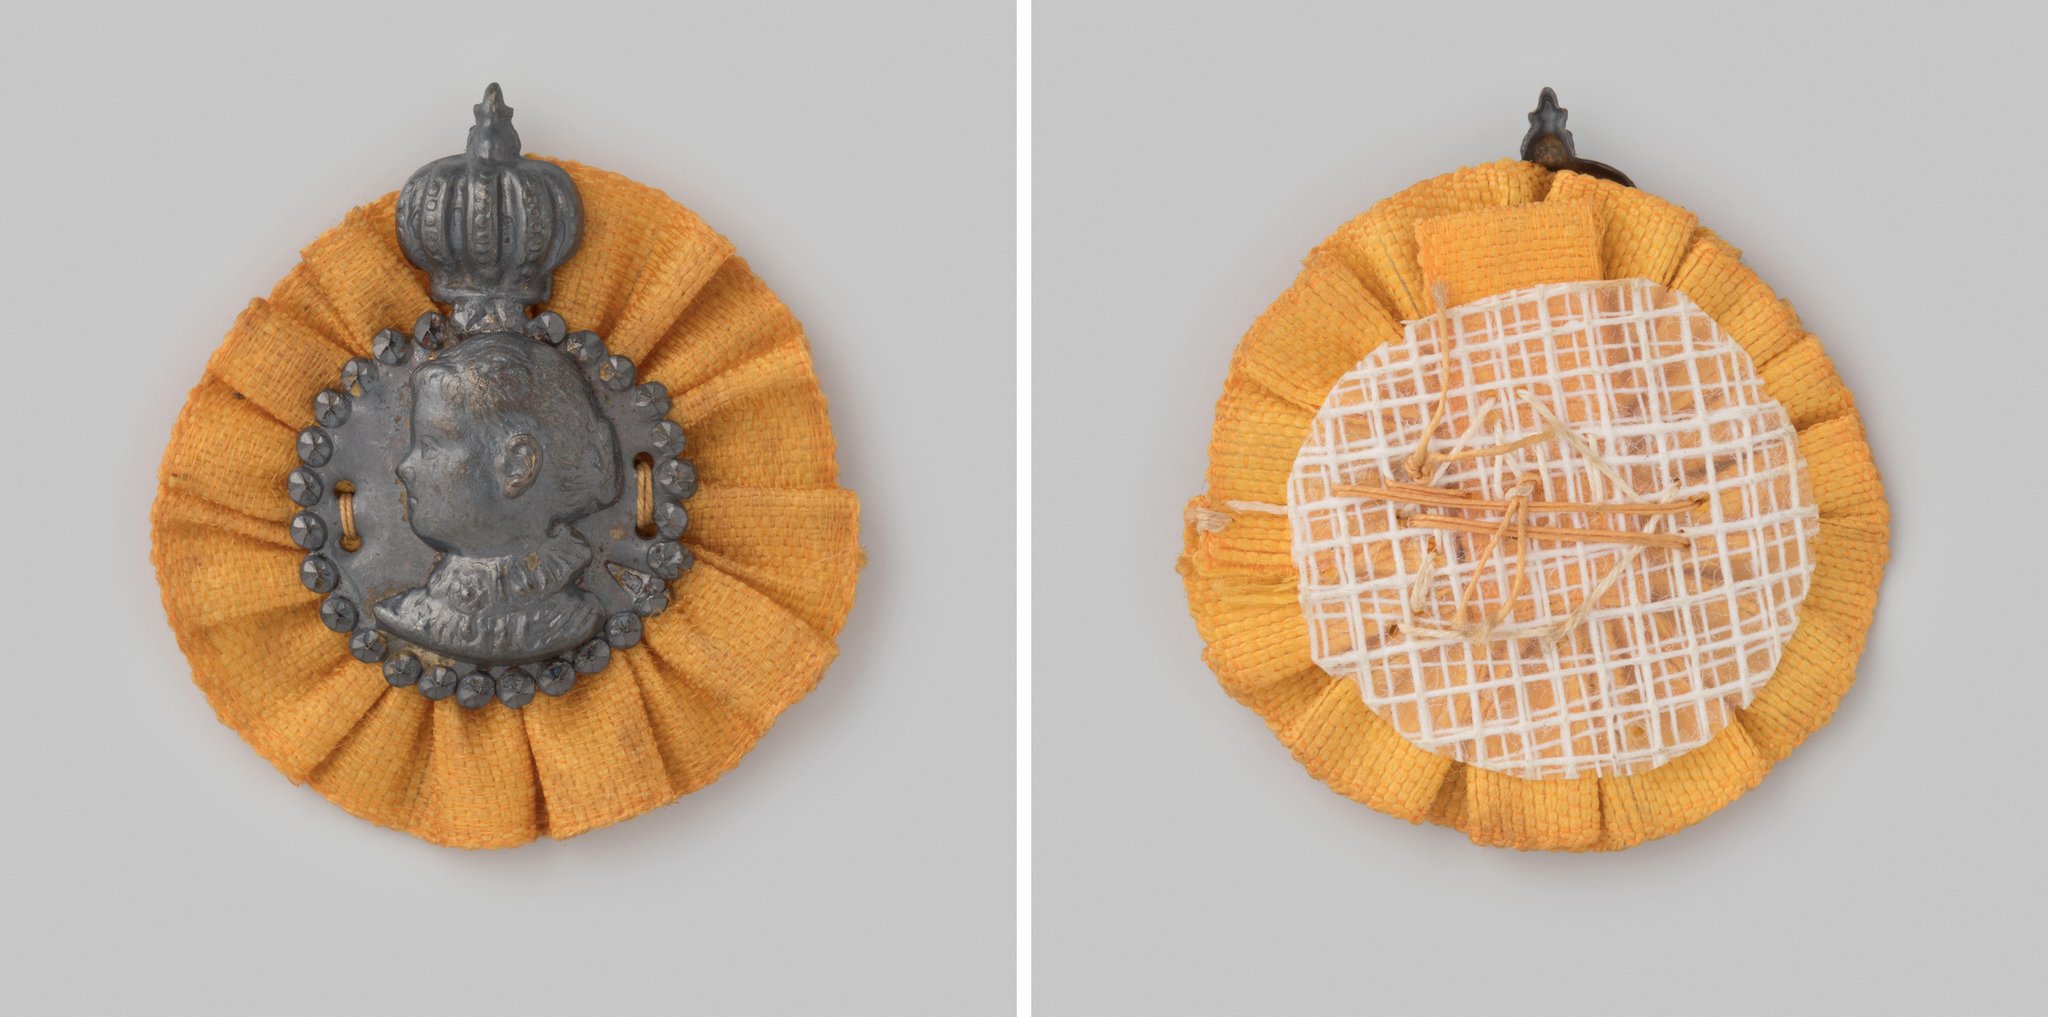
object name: history medal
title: Inhuldiging van Koningin Wilhelmina te Amsterdam 1898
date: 1898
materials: silver, textile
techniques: pressing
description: Kleine oranje cocarde met zilveren applique, voorstellend het gekroond portret van Koningin Wilhelmina naar links binnen een cirkel van diamanten.